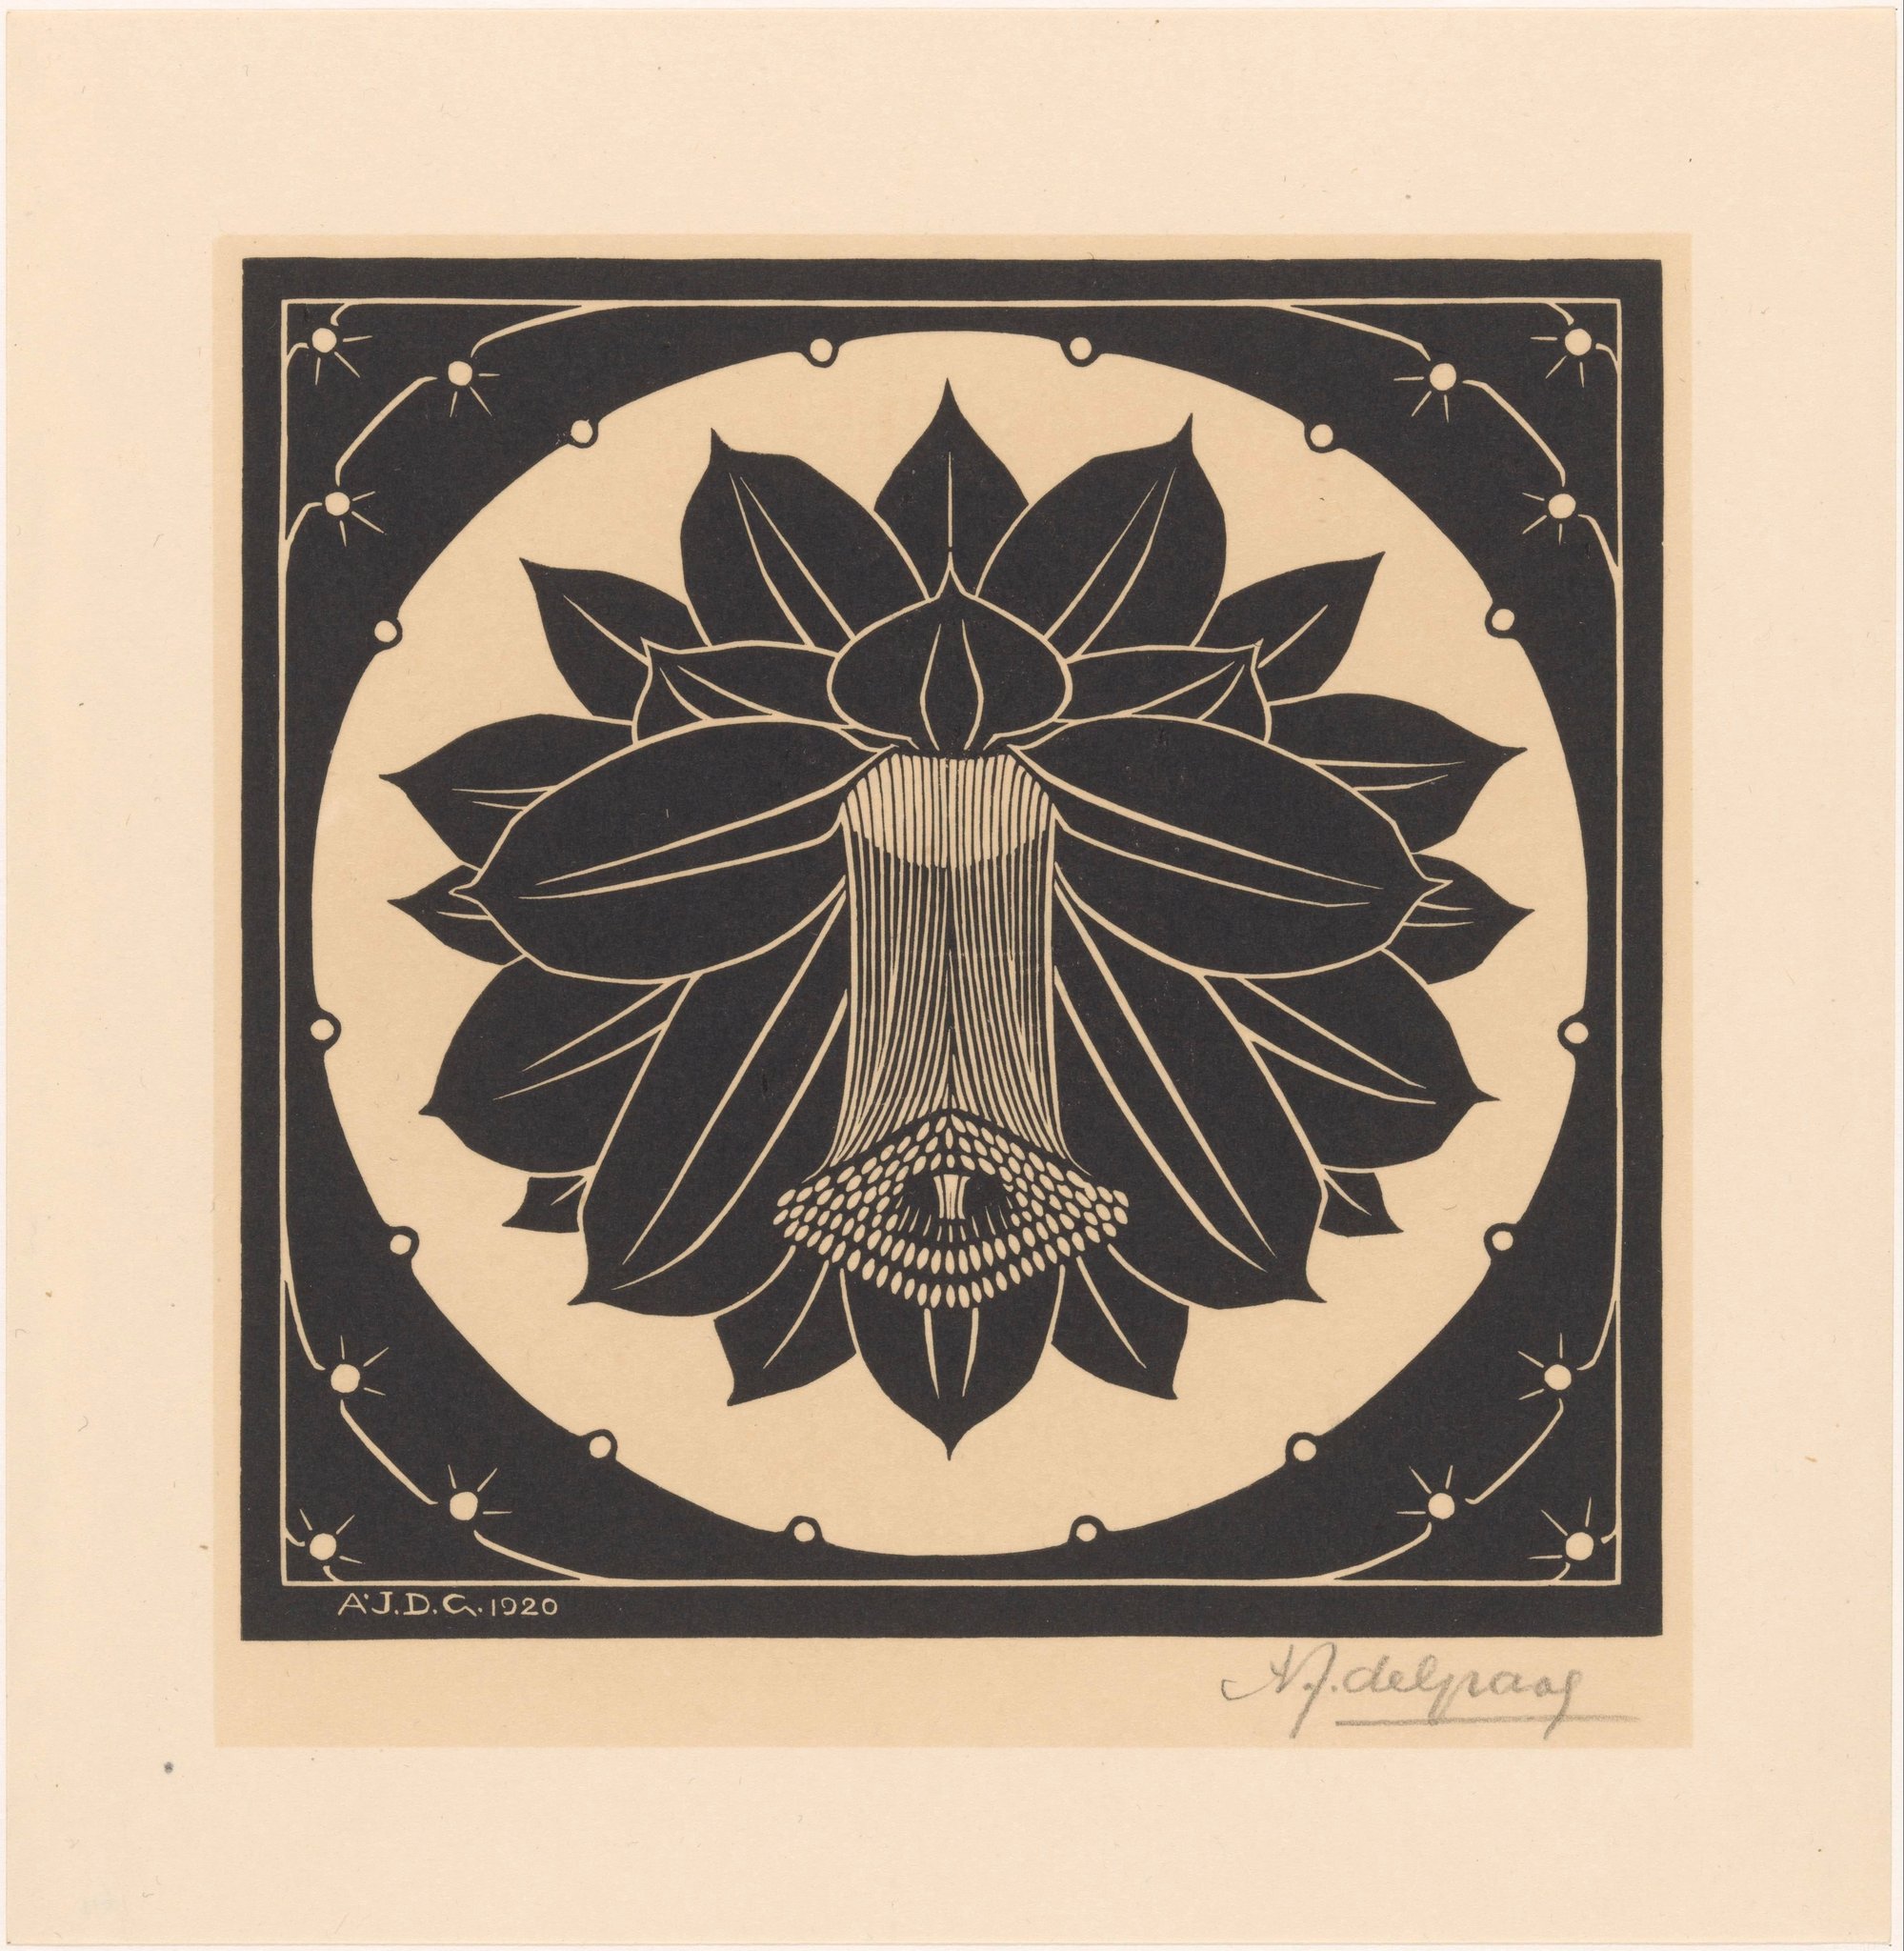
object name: print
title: Cactusbloem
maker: julie de graag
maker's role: draughtsman, print maker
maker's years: 1877-1924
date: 1920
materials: paper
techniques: woodcut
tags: flowers, plants and herbs: cactus (+ flowers, blossom, blossoming)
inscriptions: collector's mark: Lugt 2228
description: De bloem van een cactus, omringd door cactusstekels.